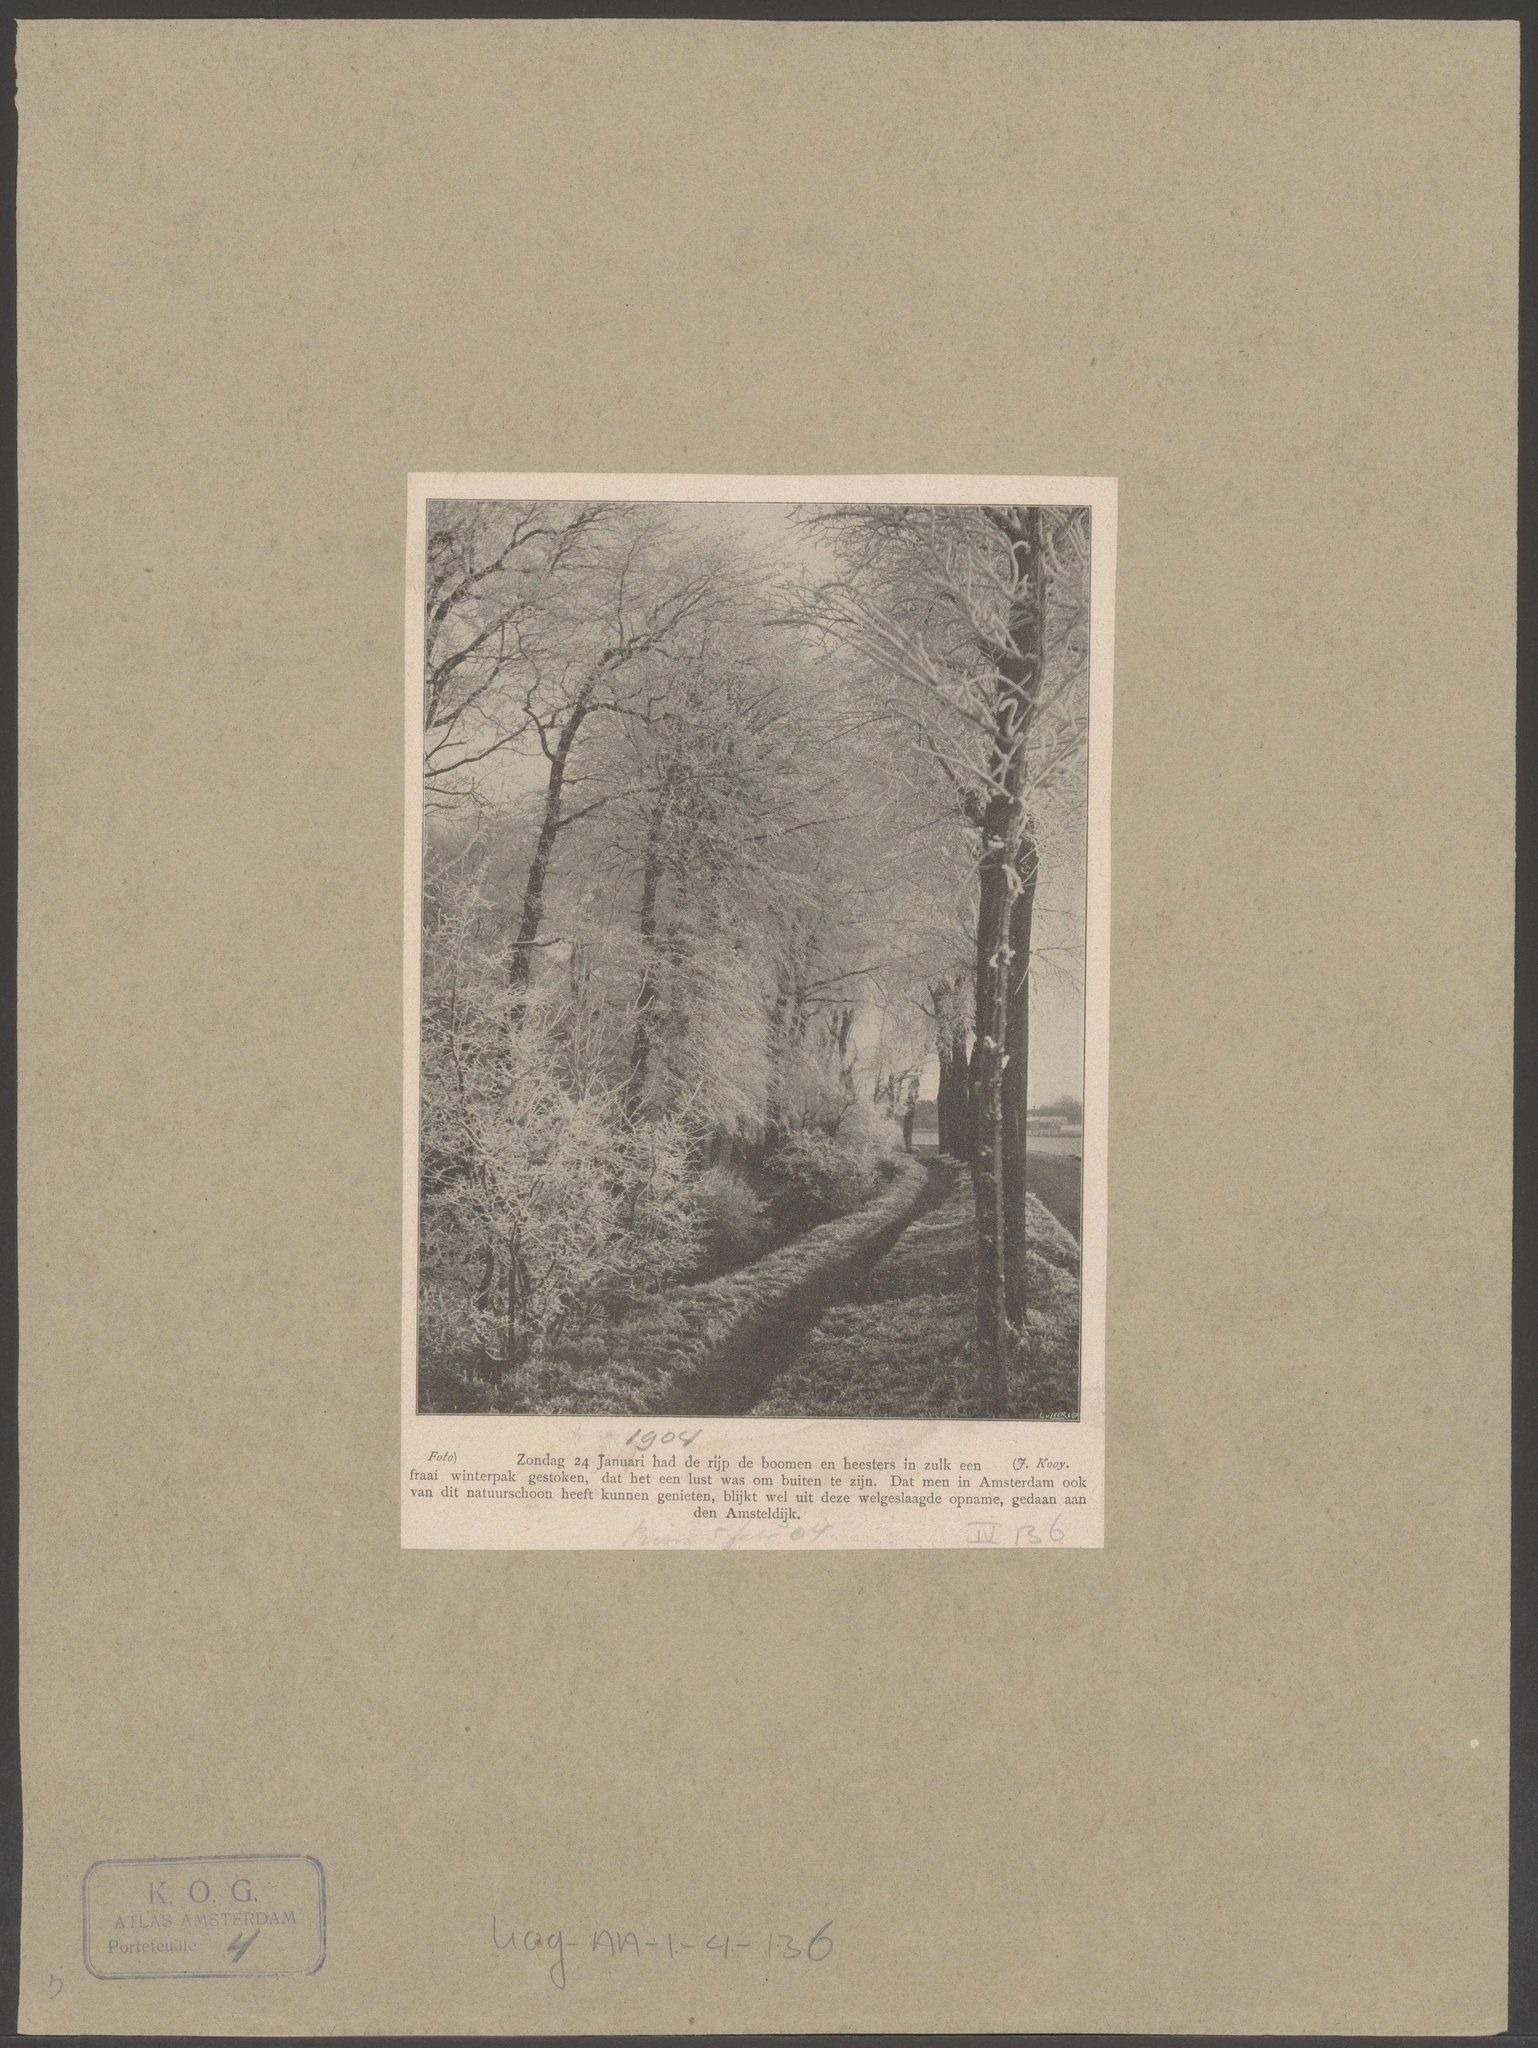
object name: photomechanical print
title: Wintergezicht op de Amsteldijk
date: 1904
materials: paper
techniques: letterpress printing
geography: amsterdam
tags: city-view in general; 'veduta', river, road, path, winter landscape; landscape symbolizing winter (the four seasons of the year), snow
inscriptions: collector's mark: ‘4’ Lugt 1641b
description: Onderwerpsrubriek binnen de Atlas Amsterdam: Amstel van Hogesluis stroomopwaarts.